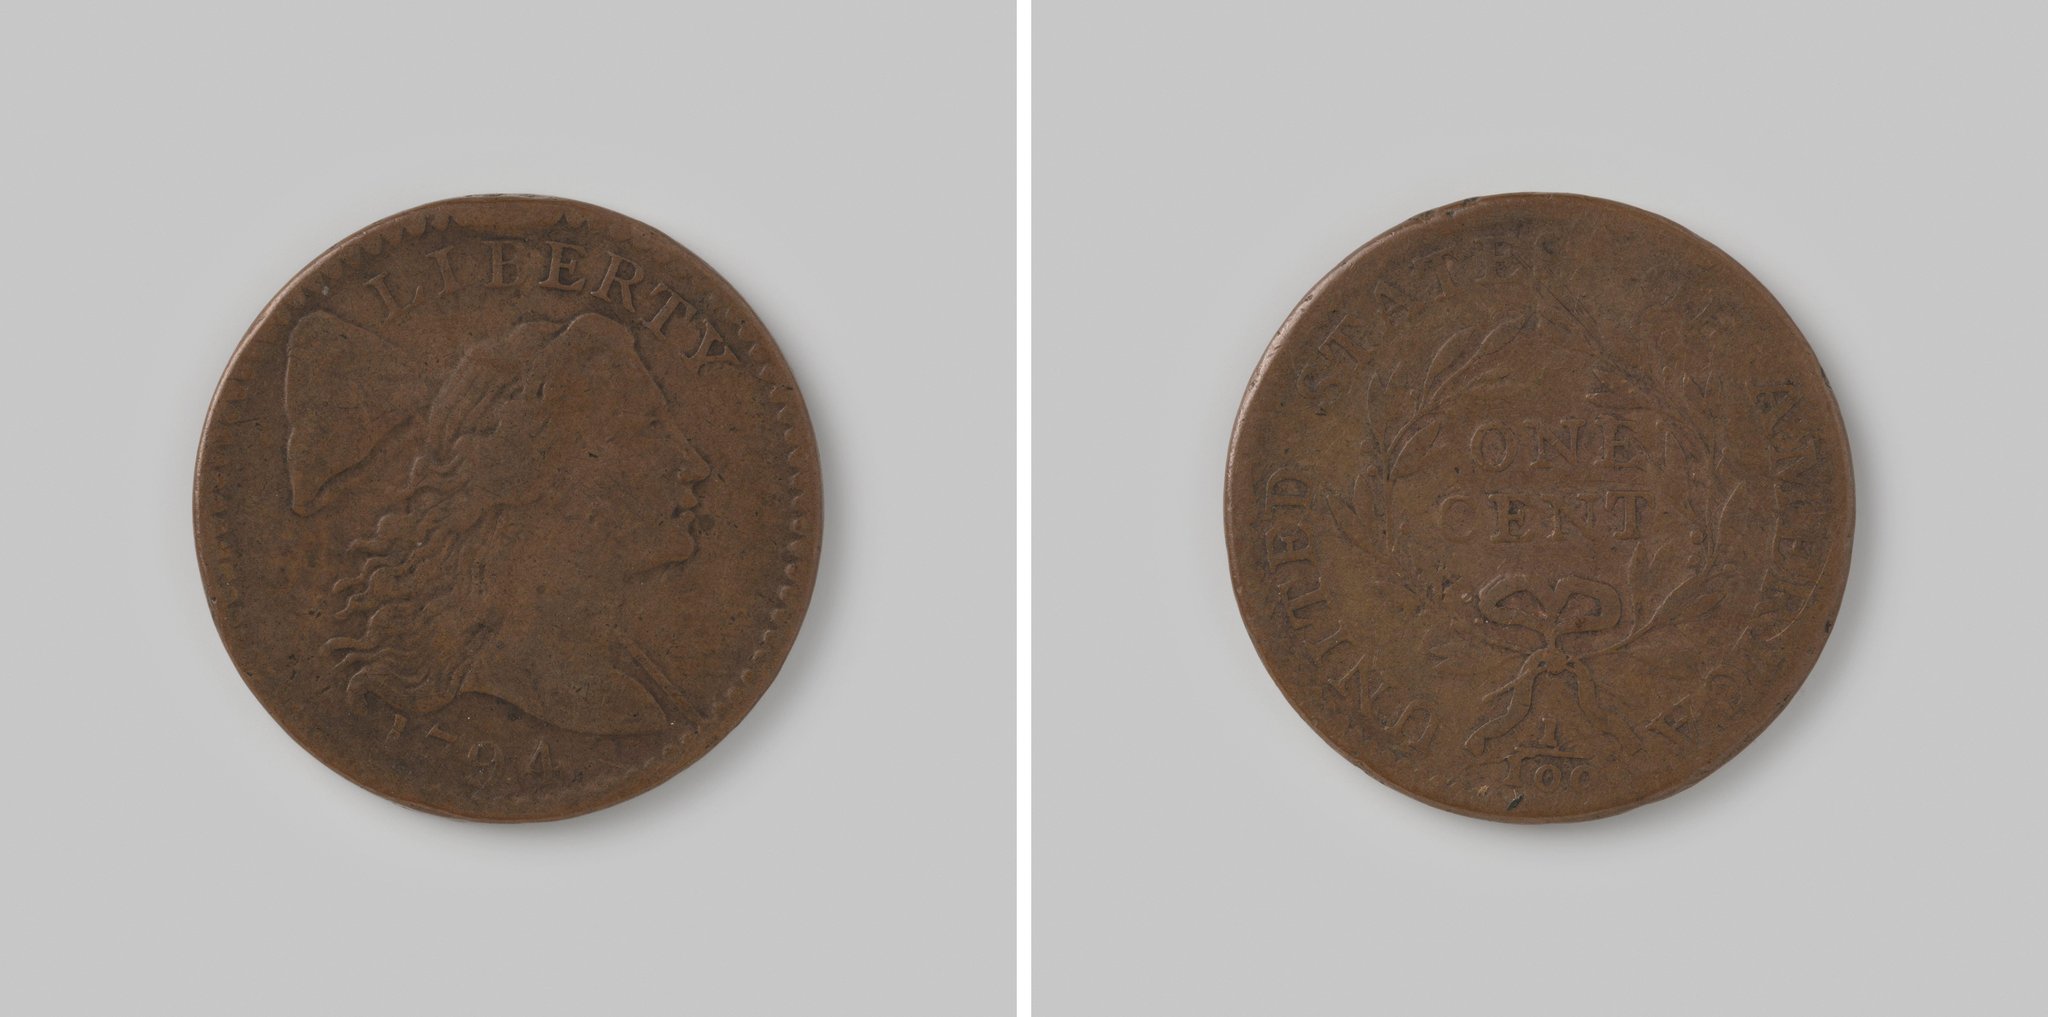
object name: coin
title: Verenigde Staten van Amerika, cent, 1794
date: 1794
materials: copper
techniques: striking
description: Koperen munt. Voorzijde: liberty naar rechts met links van haar hoofd vrijheidshoed (cap). Onderaan jaartal. Keerzijde: tussen twee met grote strik samengebonden takken waarde-aanduiding: one cent in twee regels. Onderaan tussen linten waarde-aanduiding: 1/100. Randschrift.